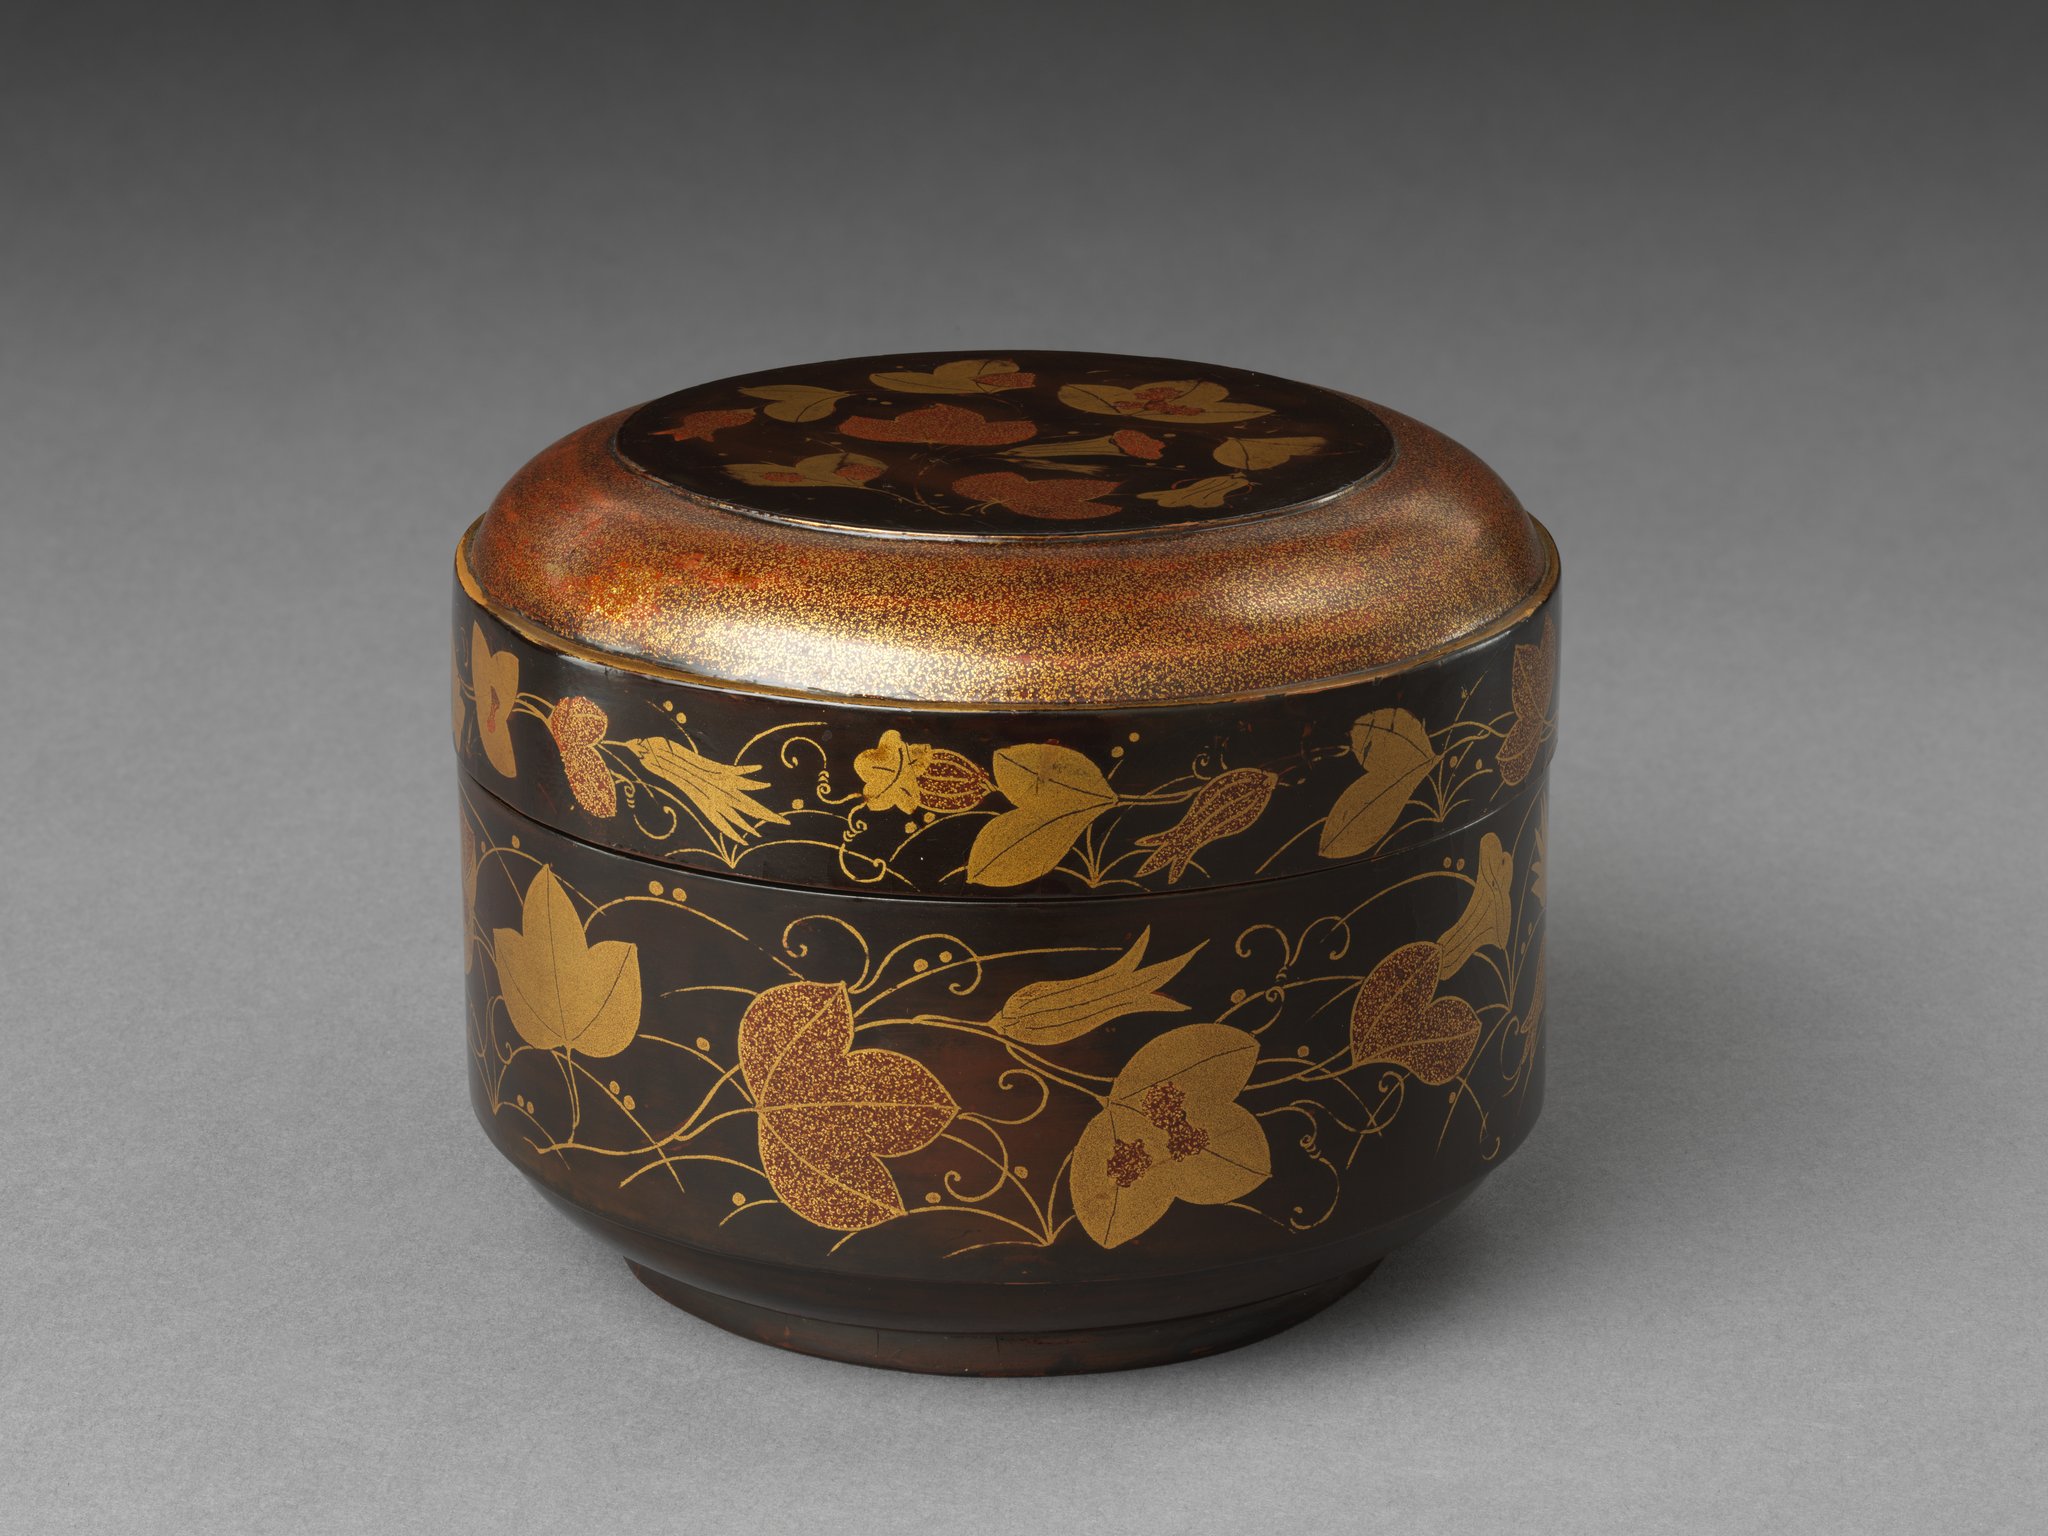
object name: food box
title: Cylindrical food box with decoration of morning glories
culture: japanese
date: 1601-1700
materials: gold, lacquer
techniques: hiramakie